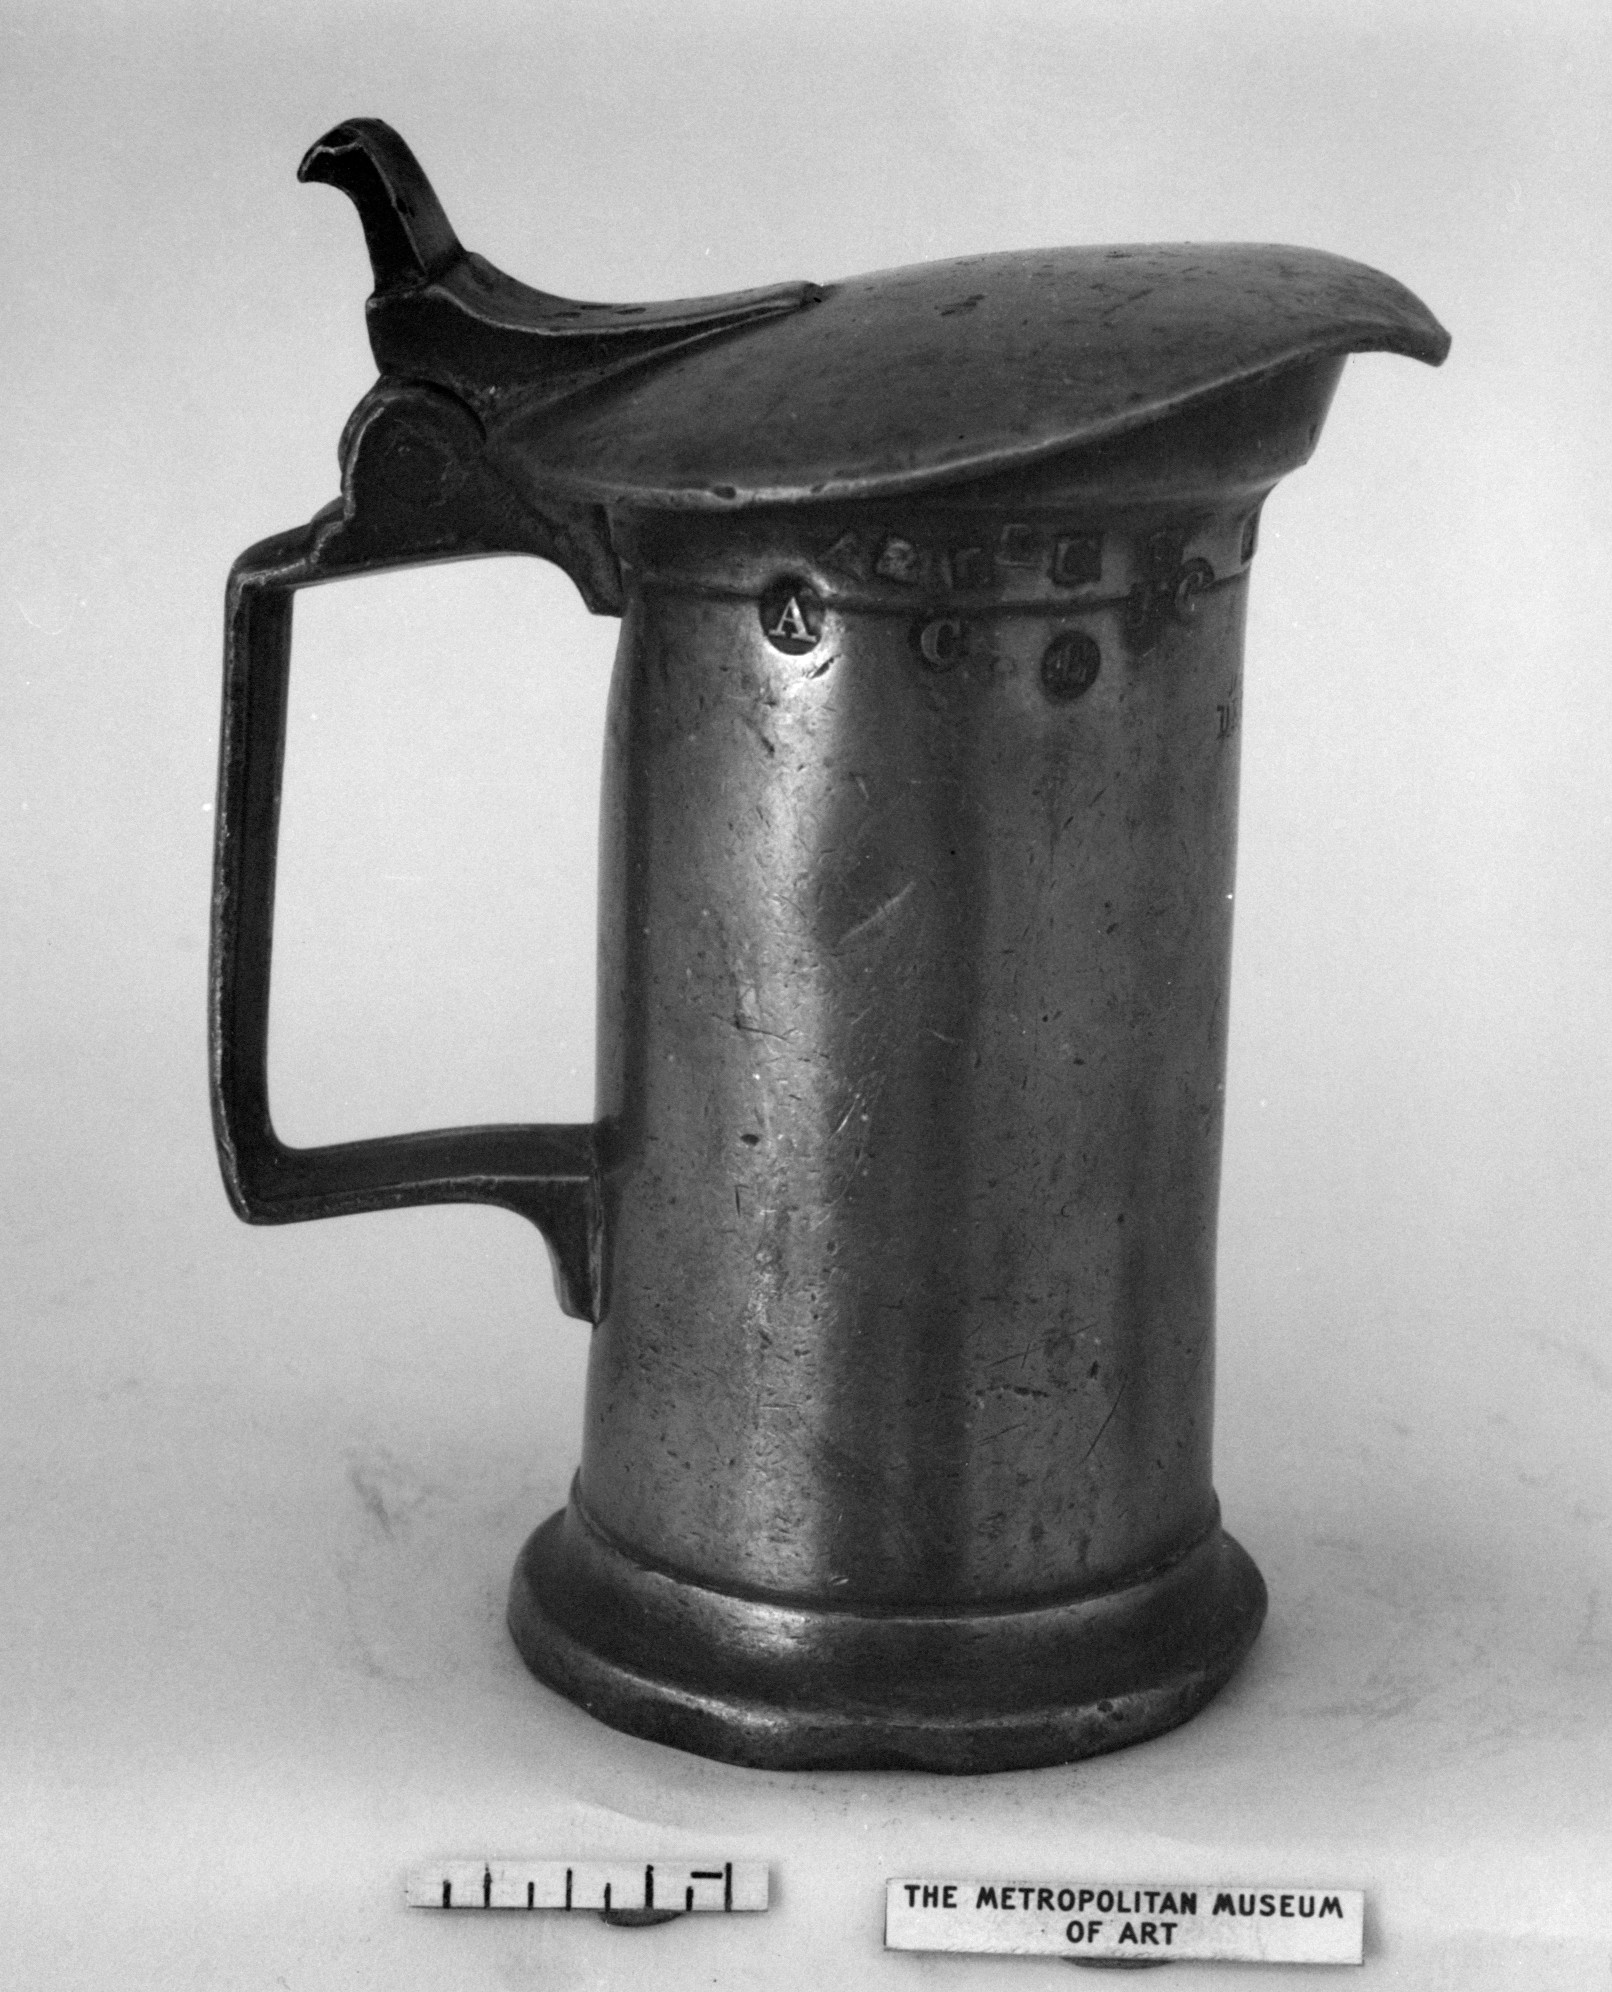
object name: measure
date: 1767-1800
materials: pewter